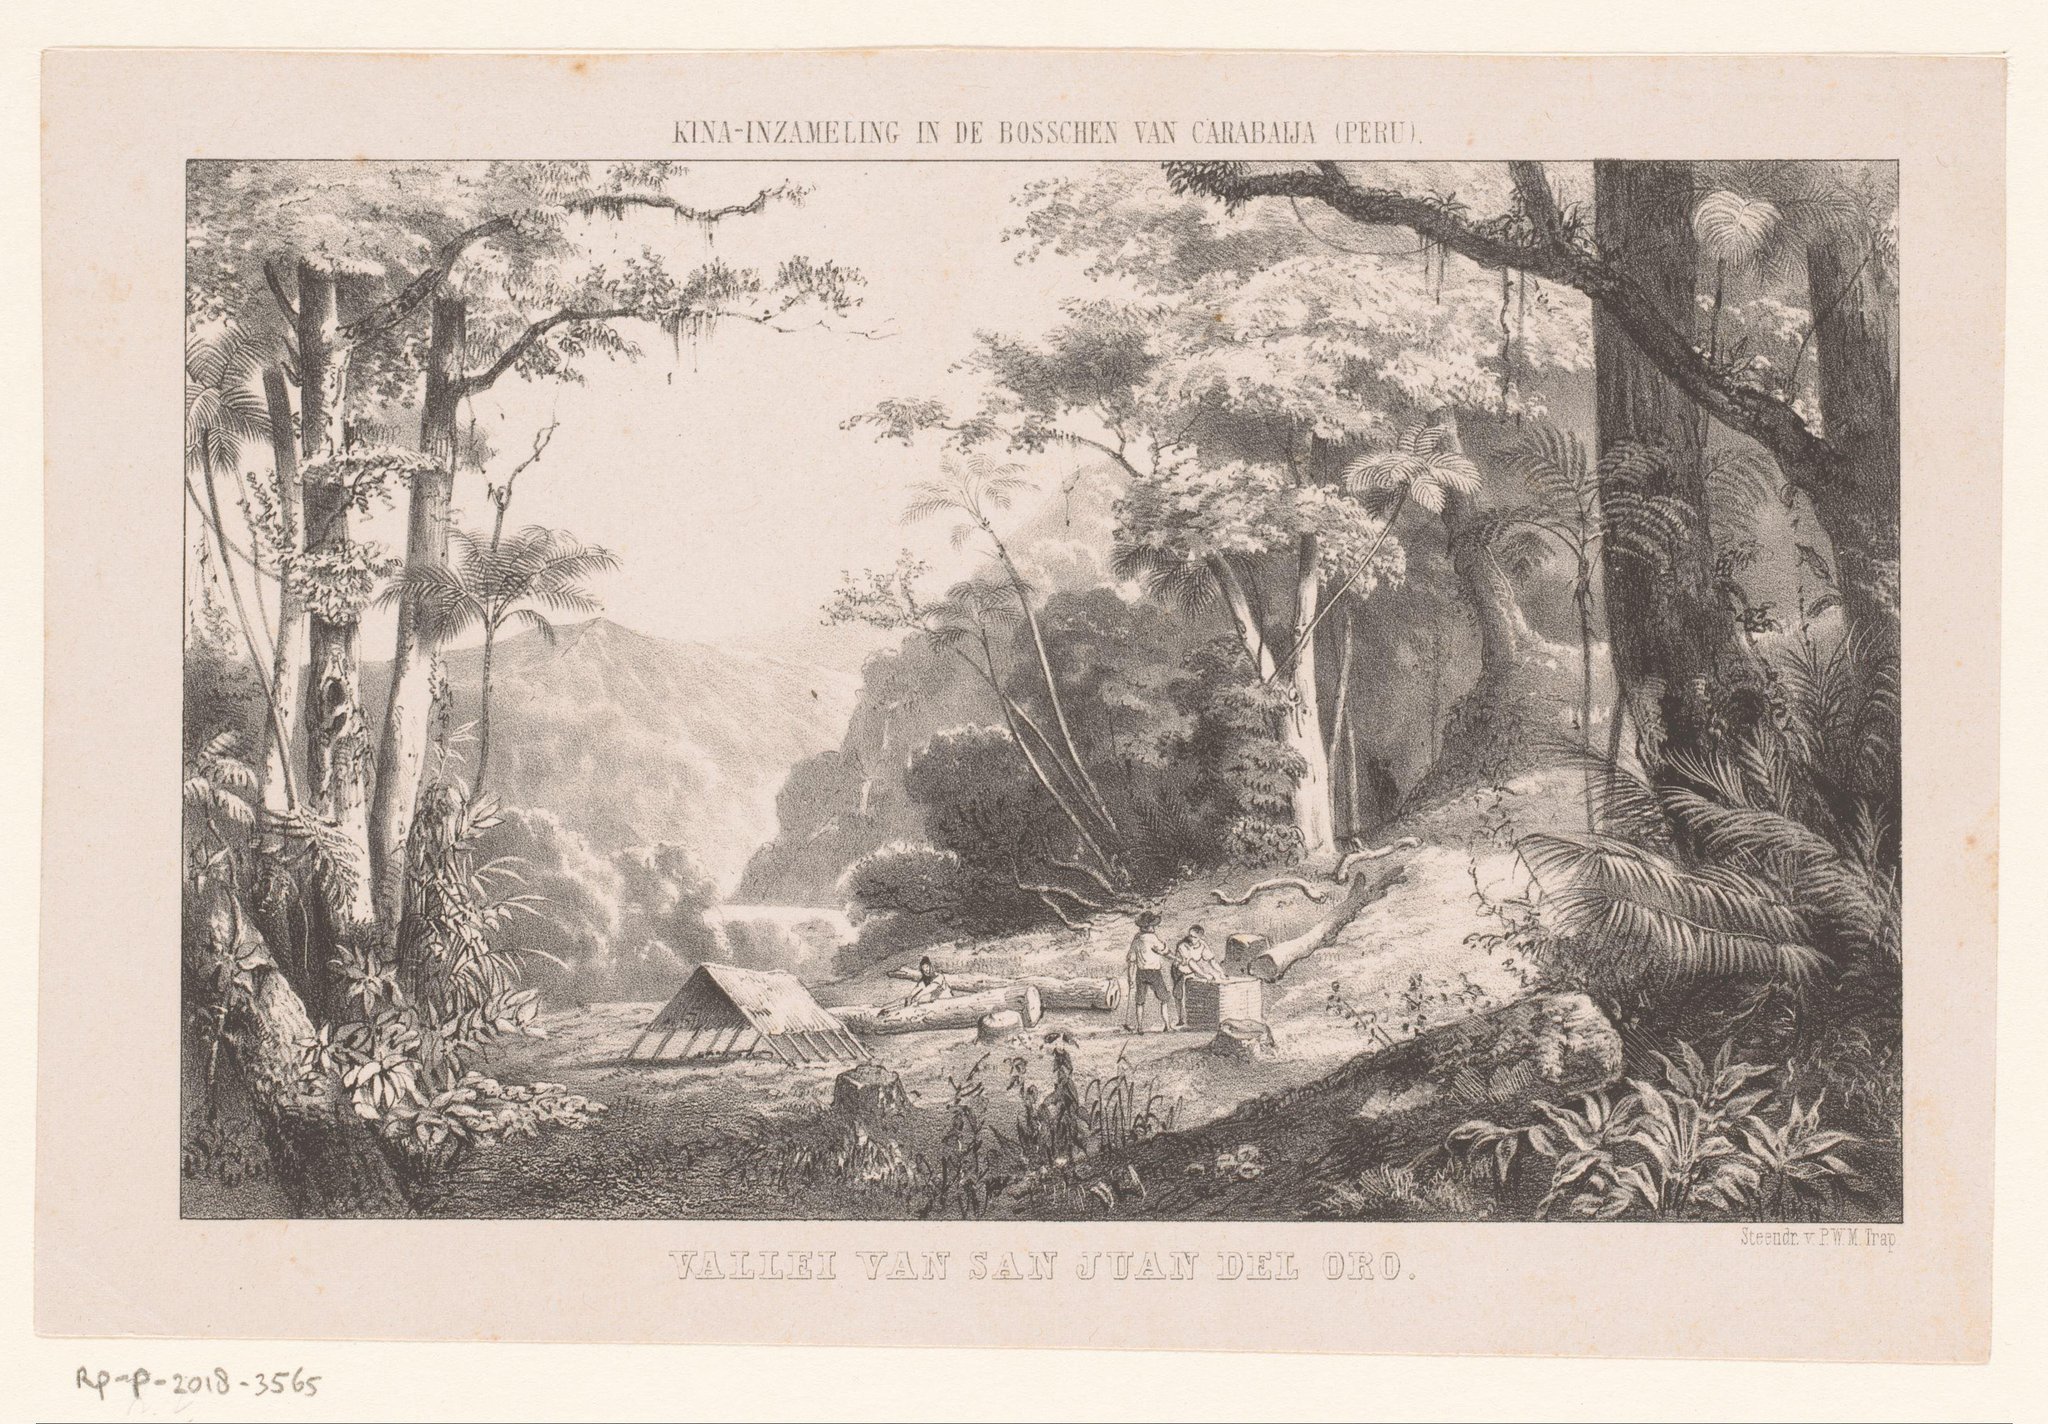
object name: print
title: Vallei van San Juan del Oro / Kina-inzameling in de bosschen van Carabaija (Peru)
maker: pieter willem marinus trap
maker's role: print maker, printer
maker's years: 1821-1905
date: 1855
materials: paper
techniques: lithograph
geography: leiden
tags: forest, wood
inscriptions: collector's mark: Lugt 2228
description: Prent verschenen in: Vriese, Willem Hendrik de. Tuinbouw-flora van Nederland en zijne overzeesche bezittingen; bevattende de geschiedenis en afbeeldingen van nieuwe of merkwaardige planten (...). Leiden: A.W. Sythoff, 1855, dl. 2.